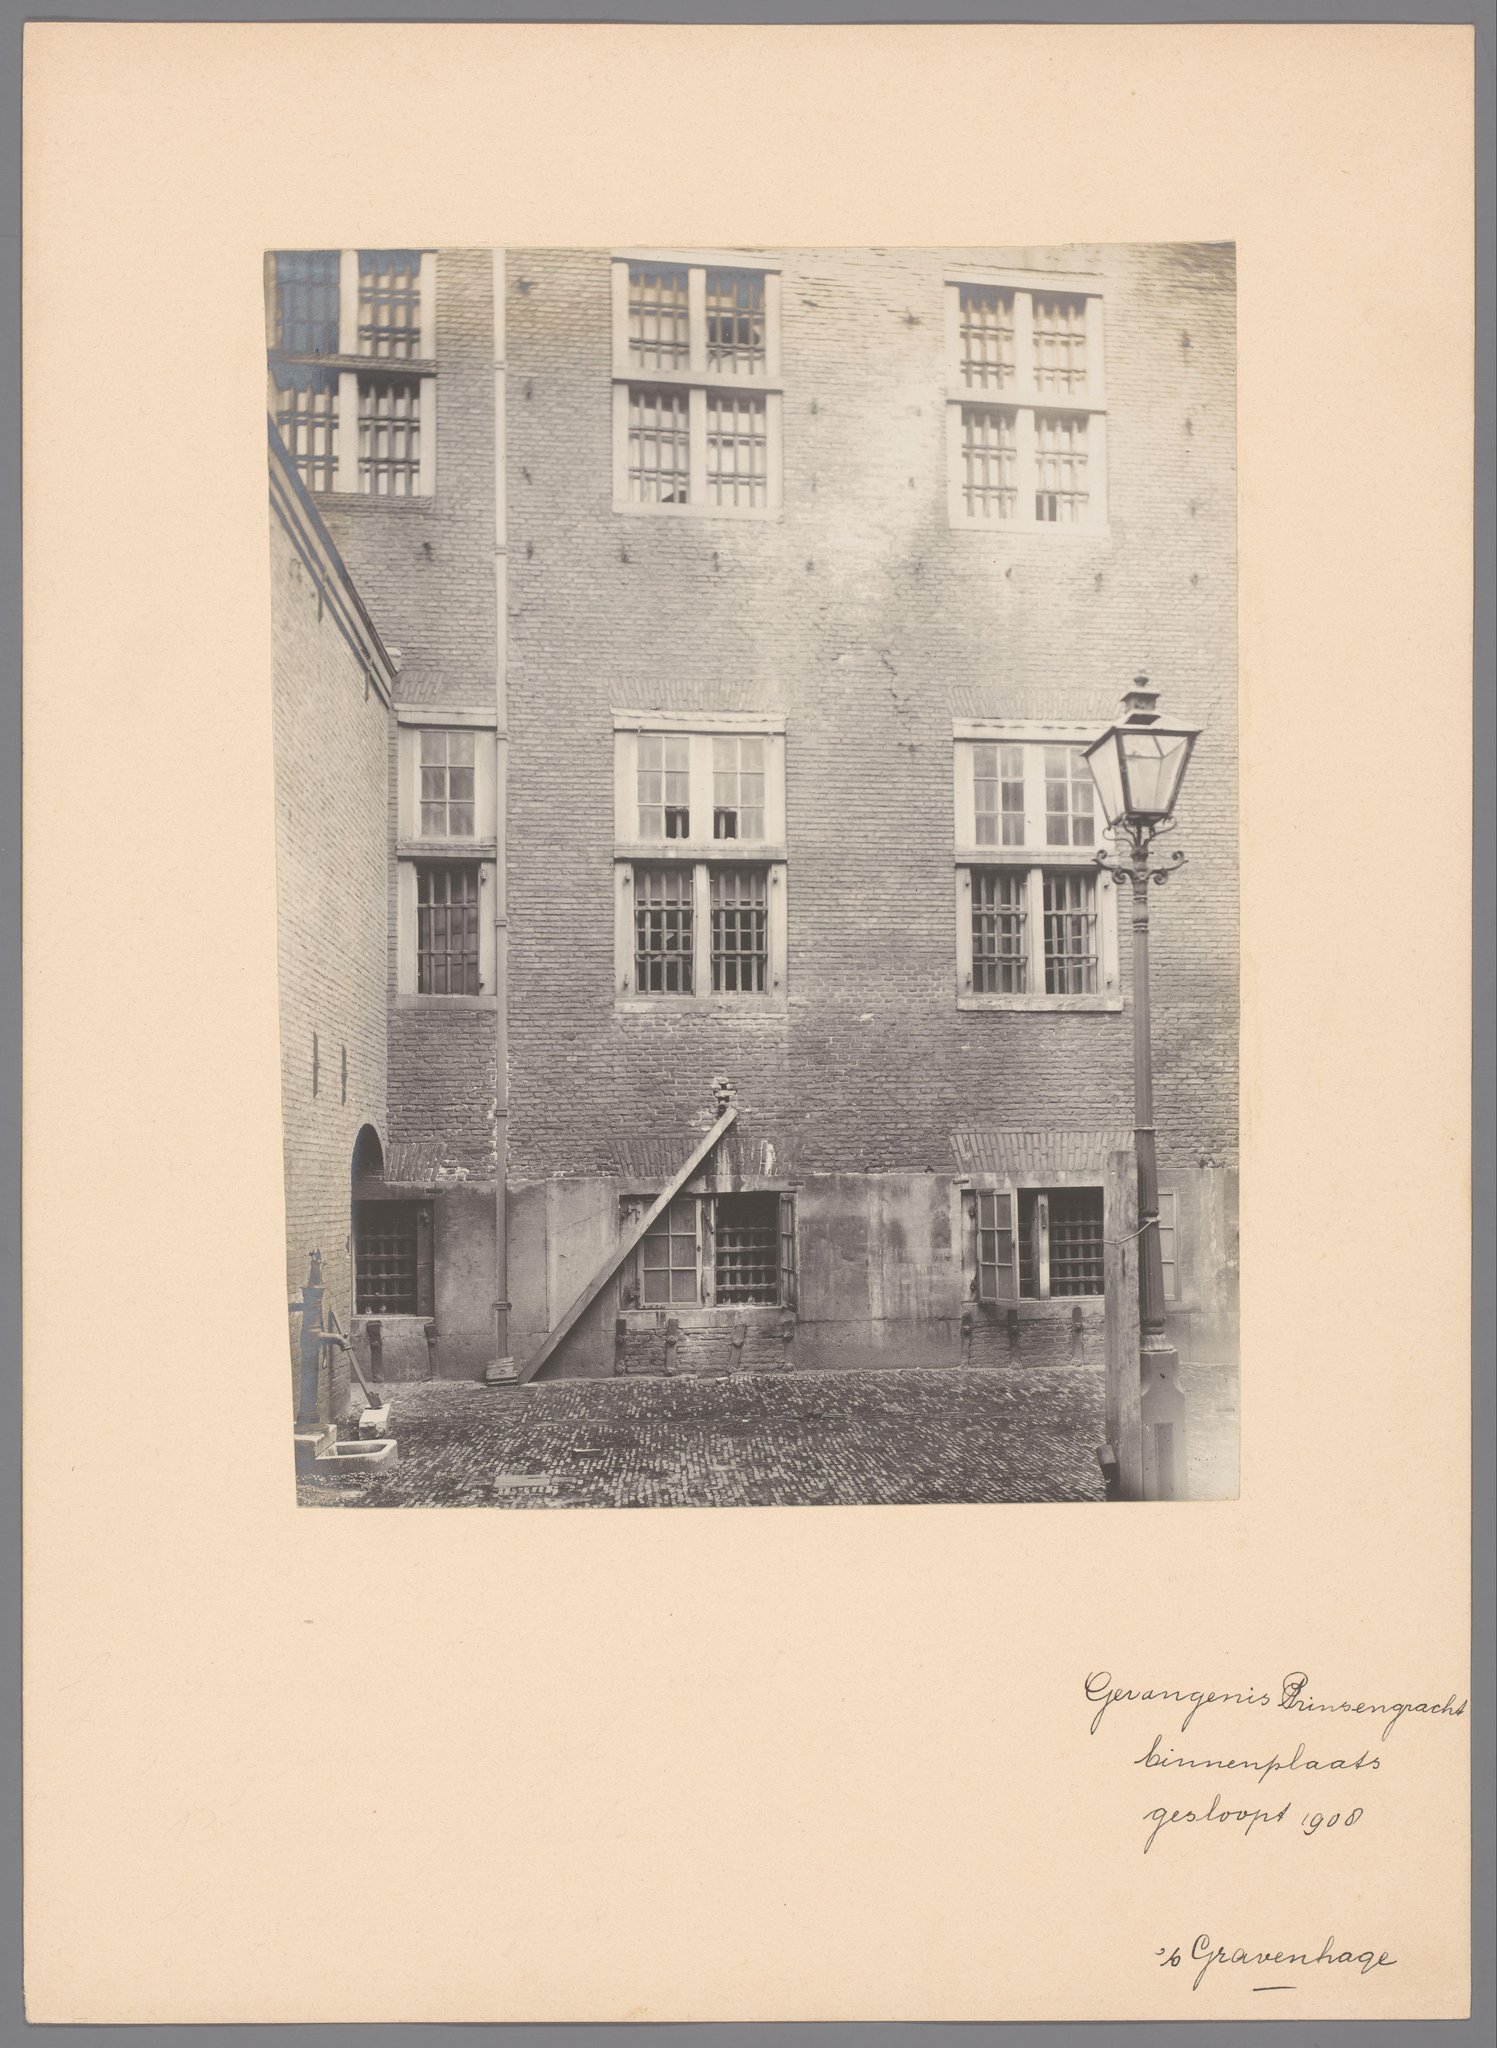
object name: photograph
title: Binnenplaats van de gevangenis op de Prinsegracht te Den Haag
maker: anoniem (monumentenzorg)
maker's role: fotograaf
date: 1900-1908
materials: cardboard, photographic support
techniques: gelatin silver print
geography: prinsegracht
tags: prison, jail, courtyard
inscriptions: annotation: ‘Gevangenis Prinsengracht/ binnenplaats/ gesloopt 1908/ 's Gravenhage’, collector's mark: ‘R:MUS.’ Lugt 2228